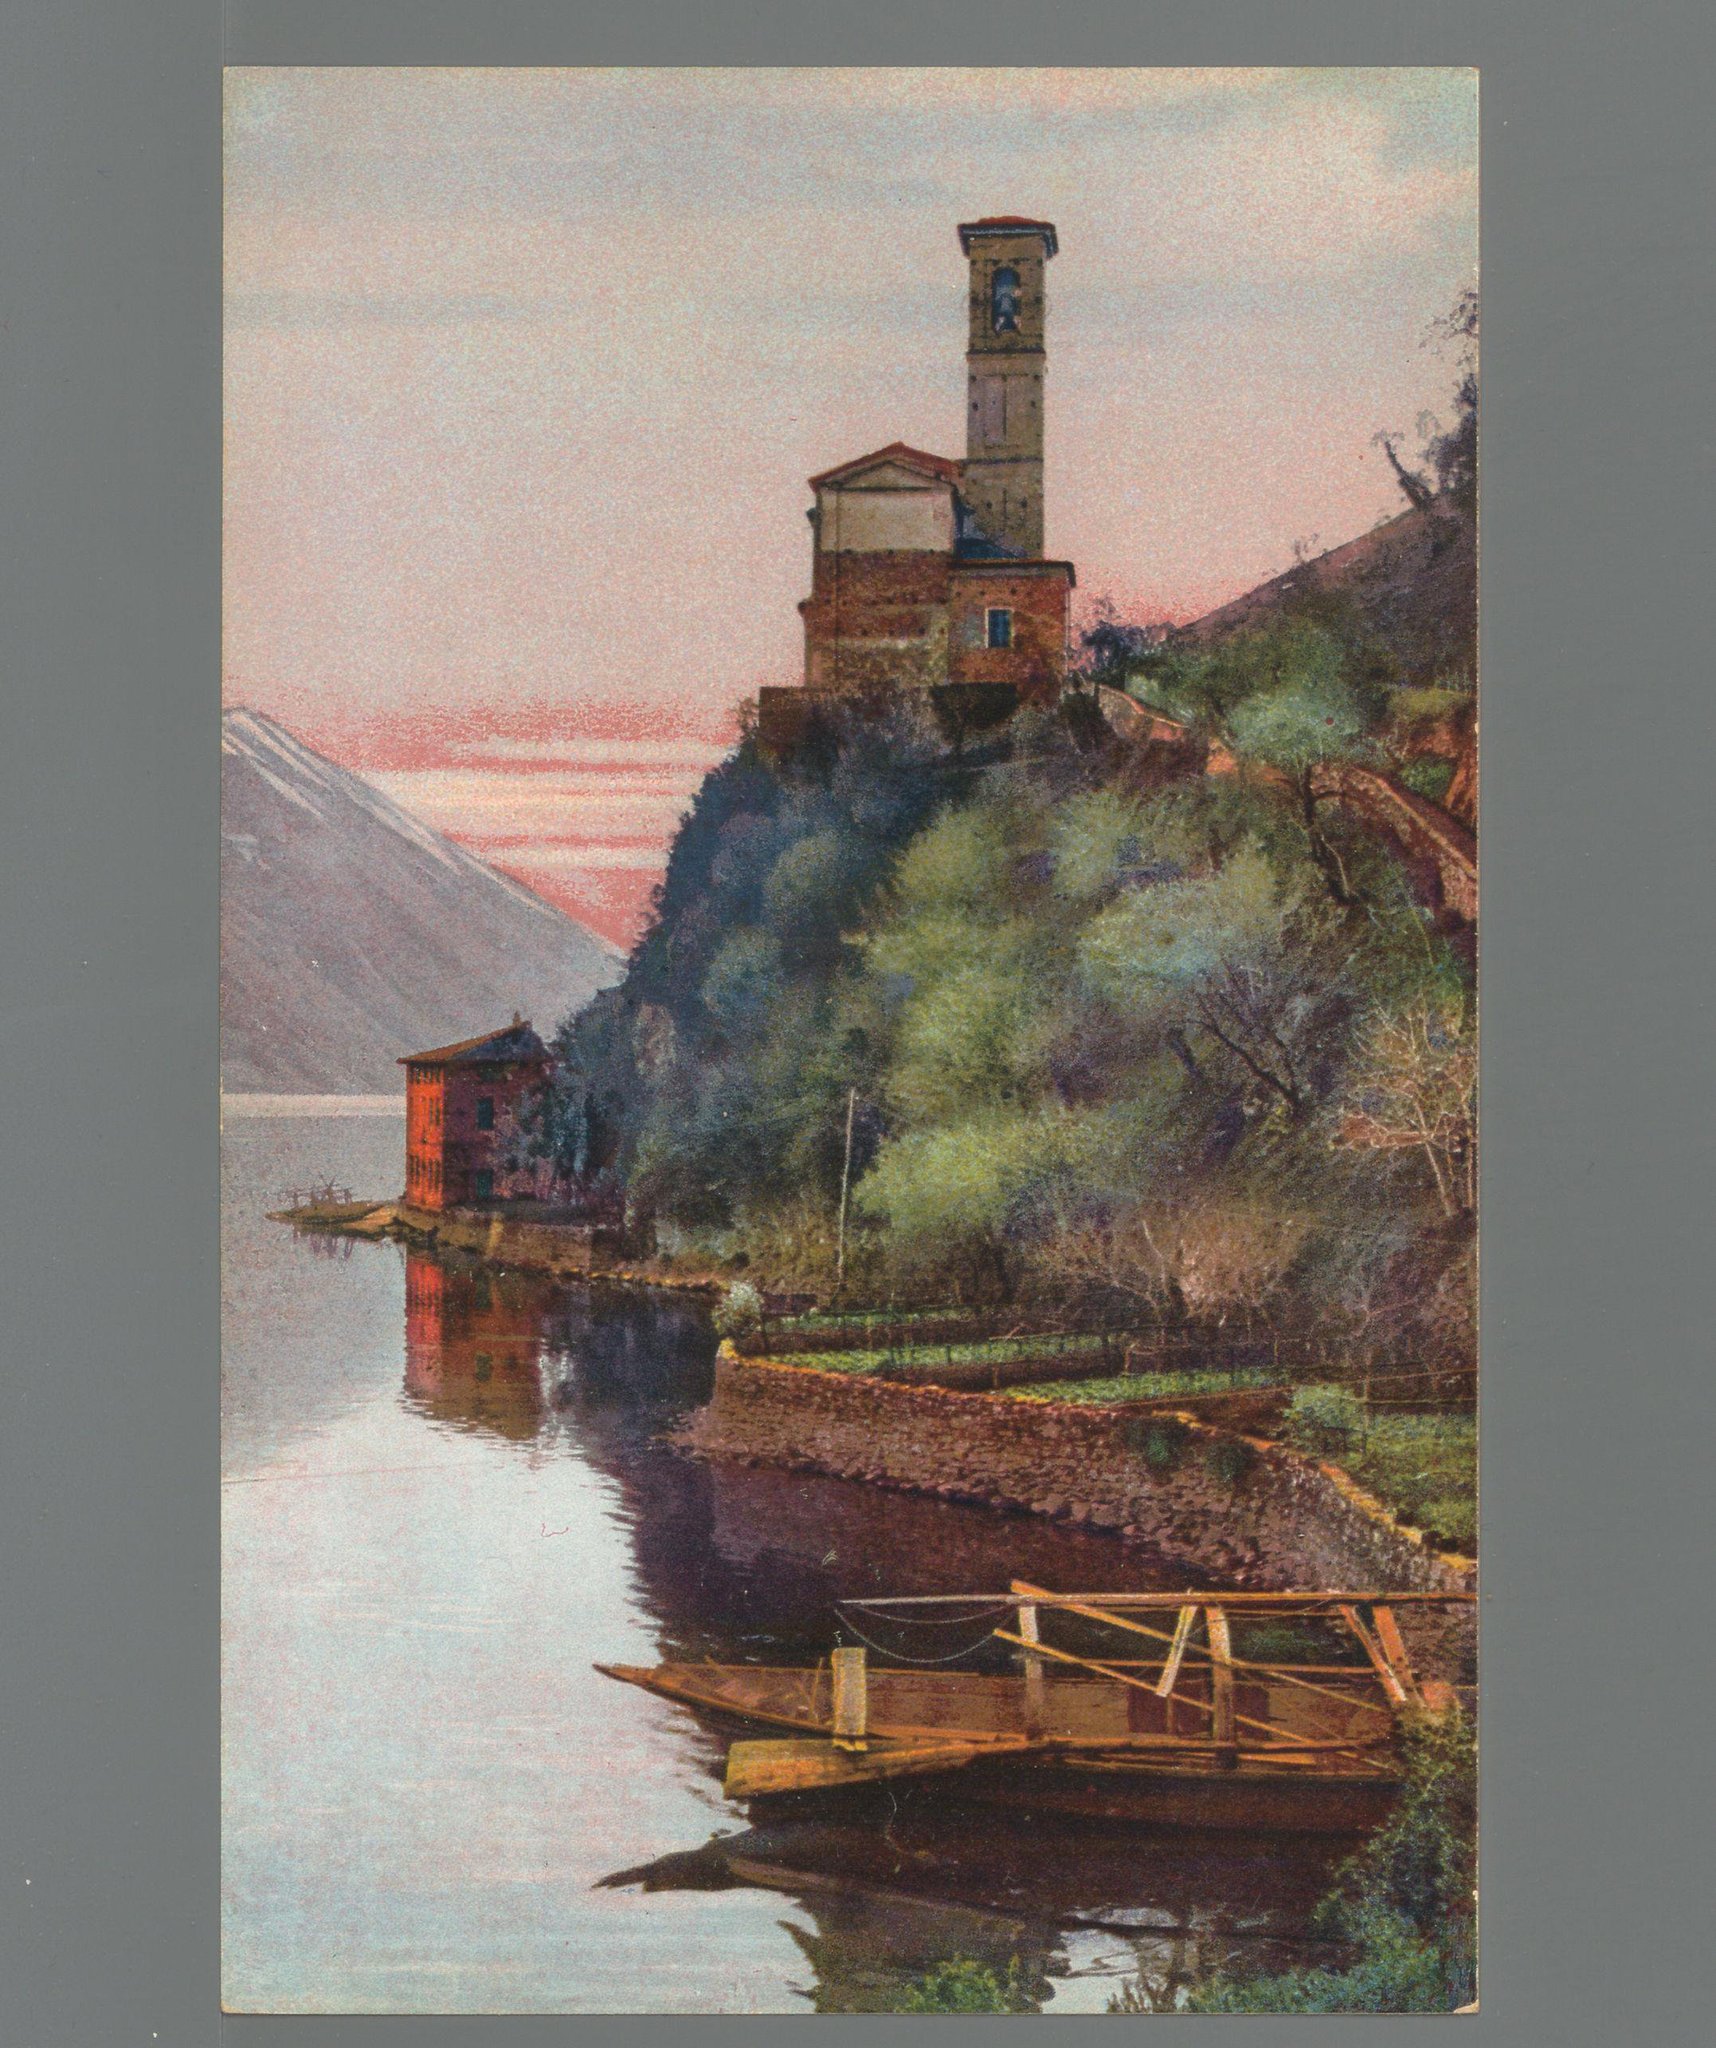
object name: ansichtkaart, prentbriefkaart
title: Lago di Lugano. Albogasio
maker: Anonymous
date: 1905-1920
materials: cardboard, photographic process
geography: albogasio-oria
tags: church (exterior), lake